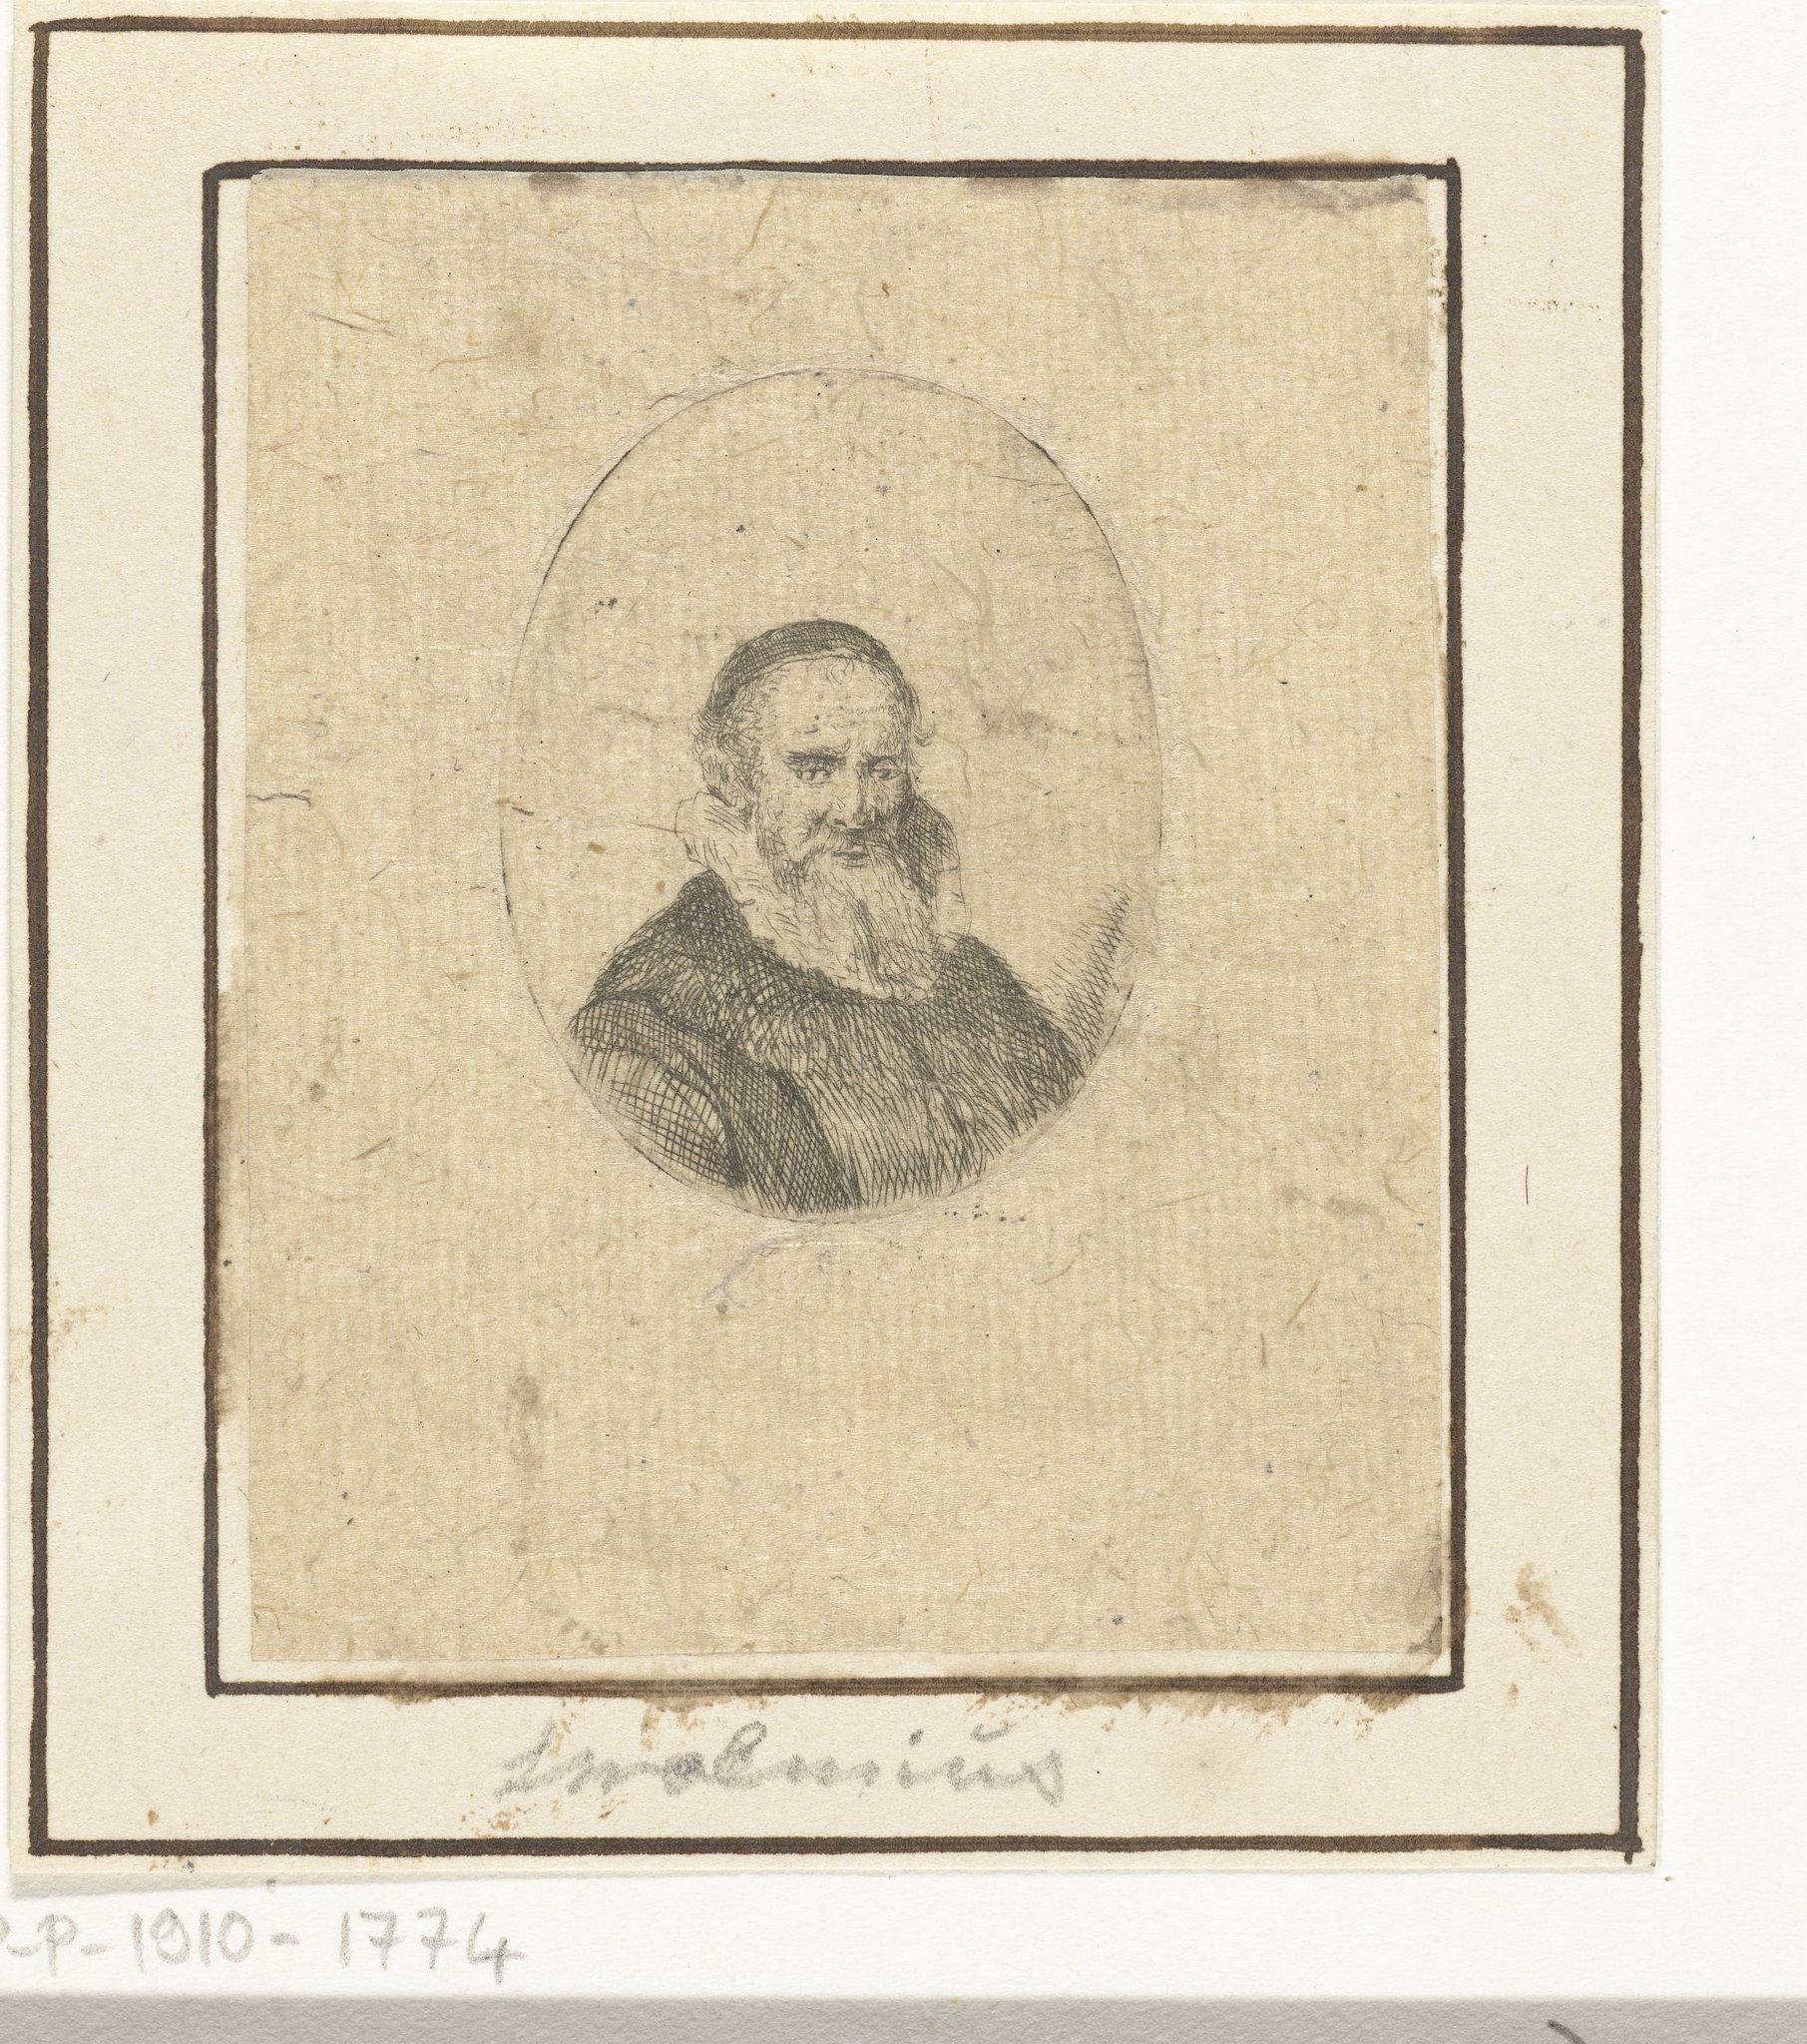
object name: print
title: Portret van de predikant Jan Cornelis Sylvius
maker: johan antoni kauclitz colizzi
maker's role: print maker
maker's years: 1742-1808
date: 1774-1808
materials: paper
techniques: etching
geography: netherlands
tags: predikant, johannes cornelisz. sylvius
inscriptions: collector's mark: Lugt 2228